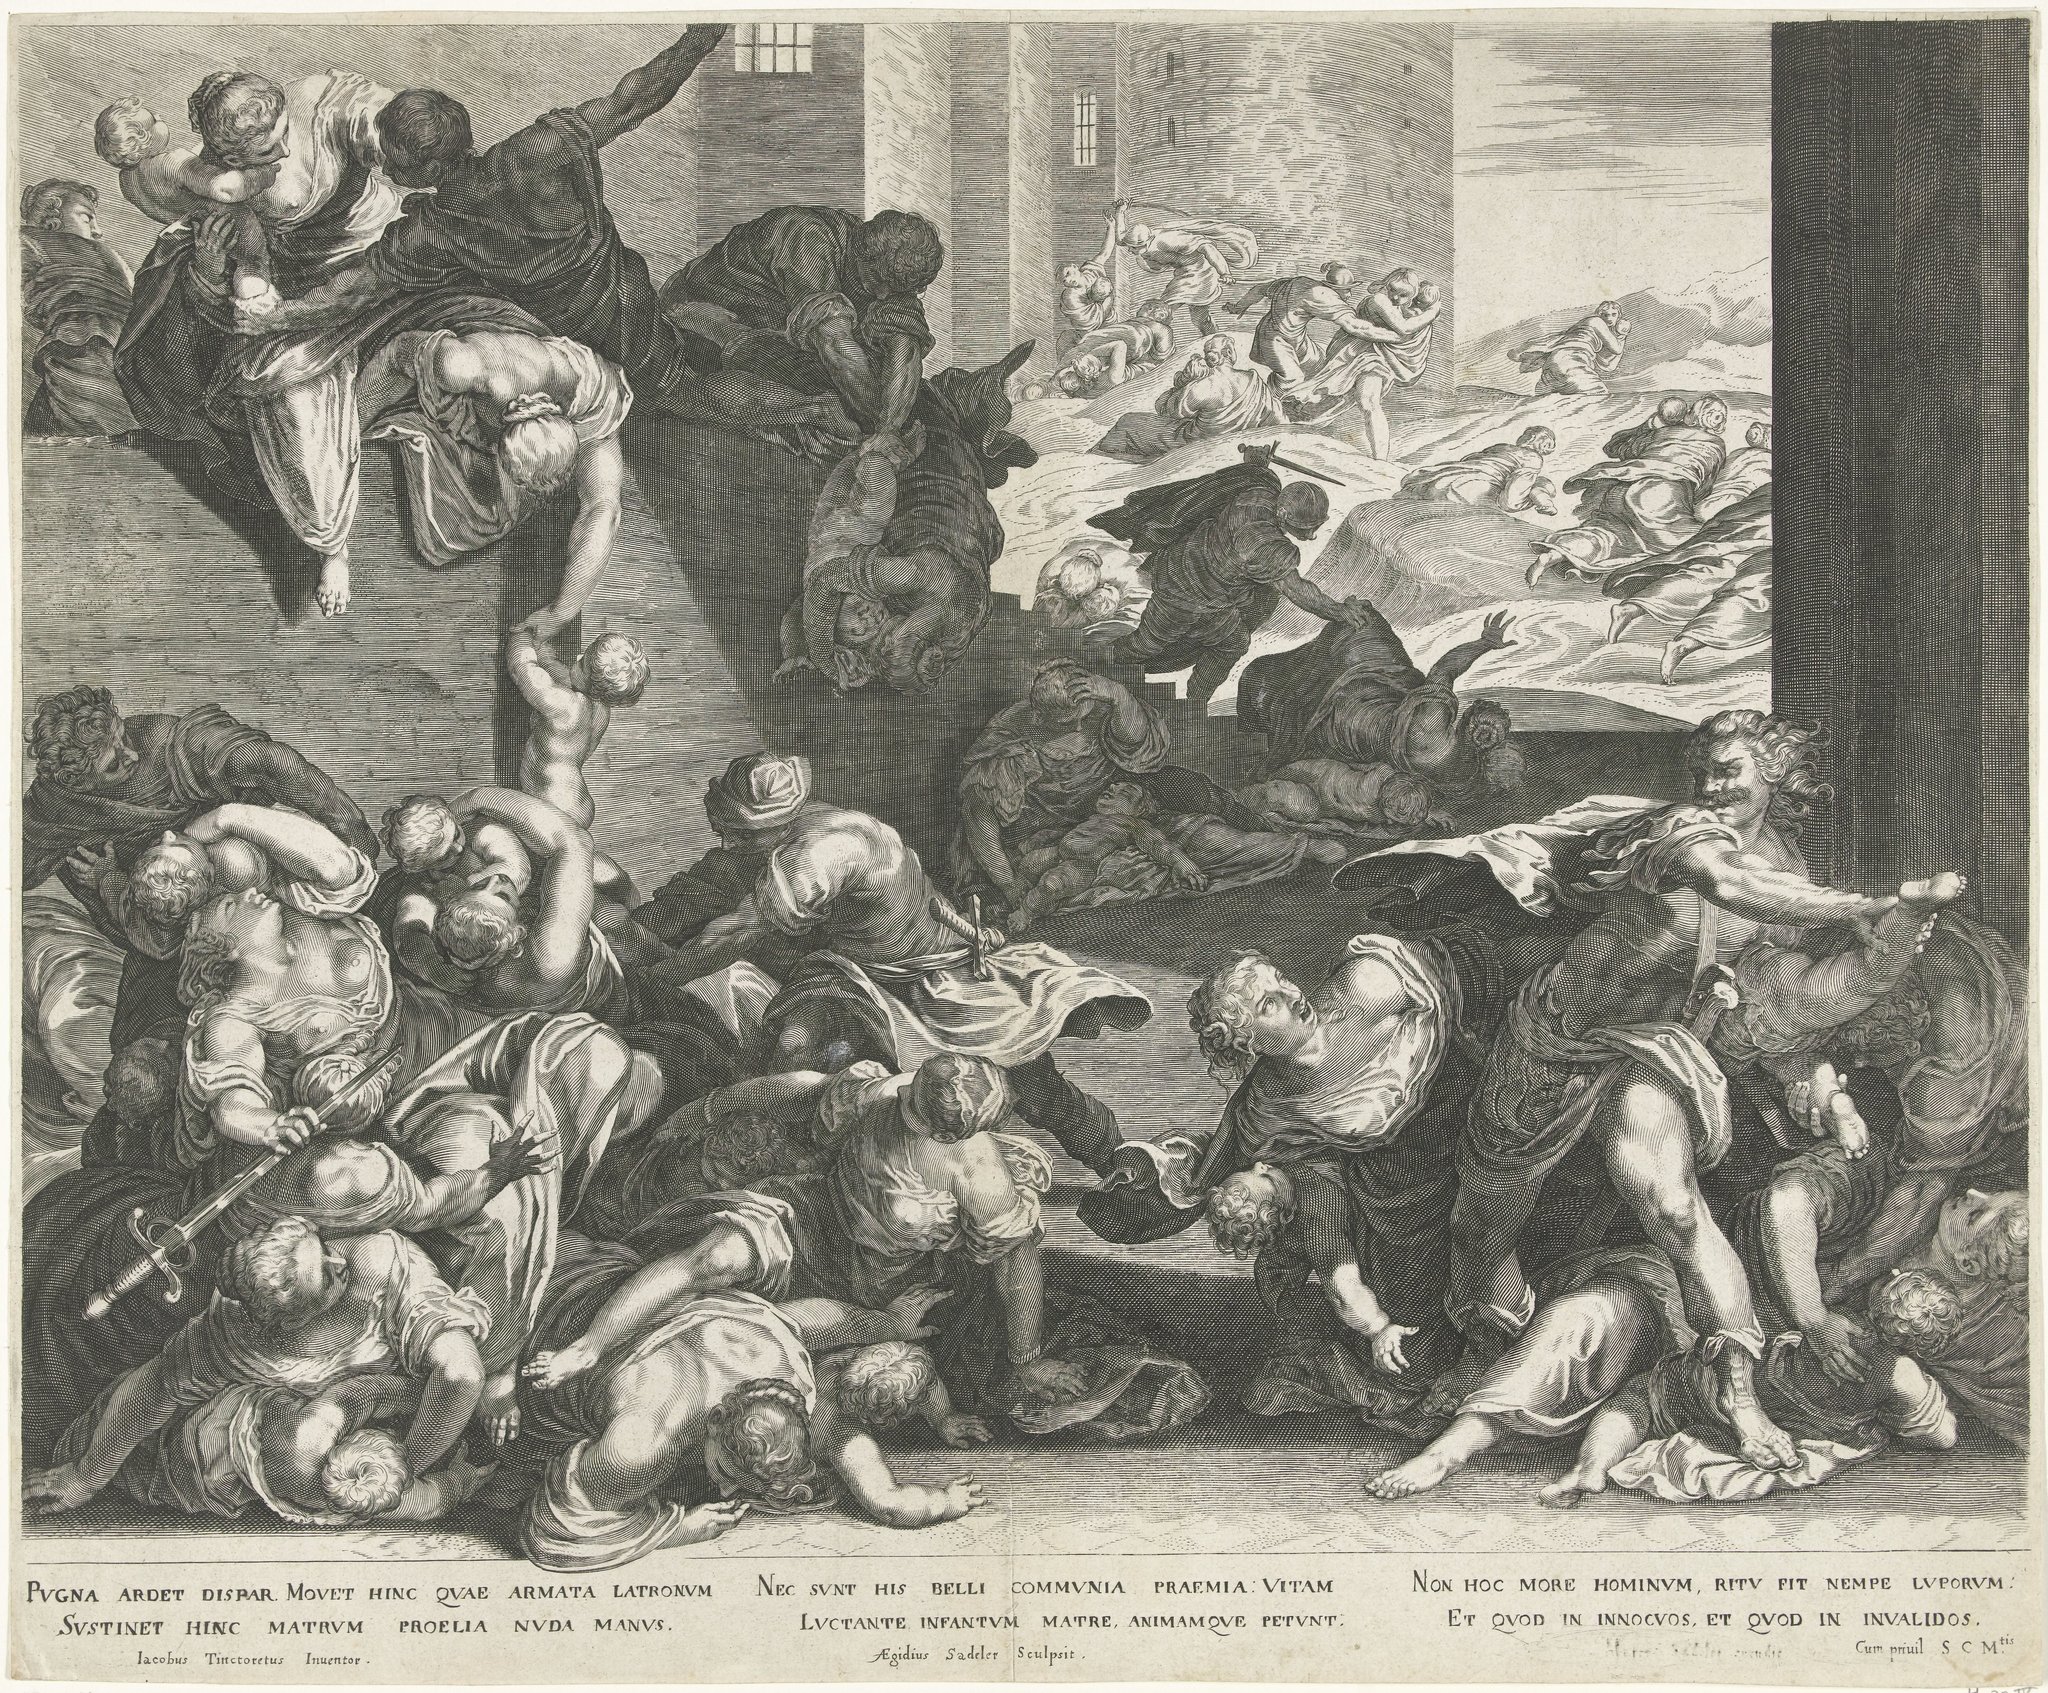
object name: print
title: Kindermoord te Betlehem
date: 1580-1629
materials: paper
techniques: engraving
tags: the massacre of the innocents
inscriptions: collector's mark: Lugt 240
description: In de straten van Betlehem proberen moeders hun kinderen te beschermen tegen de soldaten van Herodes. De soldaten hebben de opdracht gekregen alle jongens van twee jaar en jonger te vermoorden. De prent heeft een Latijns onderschrift met uitleg.